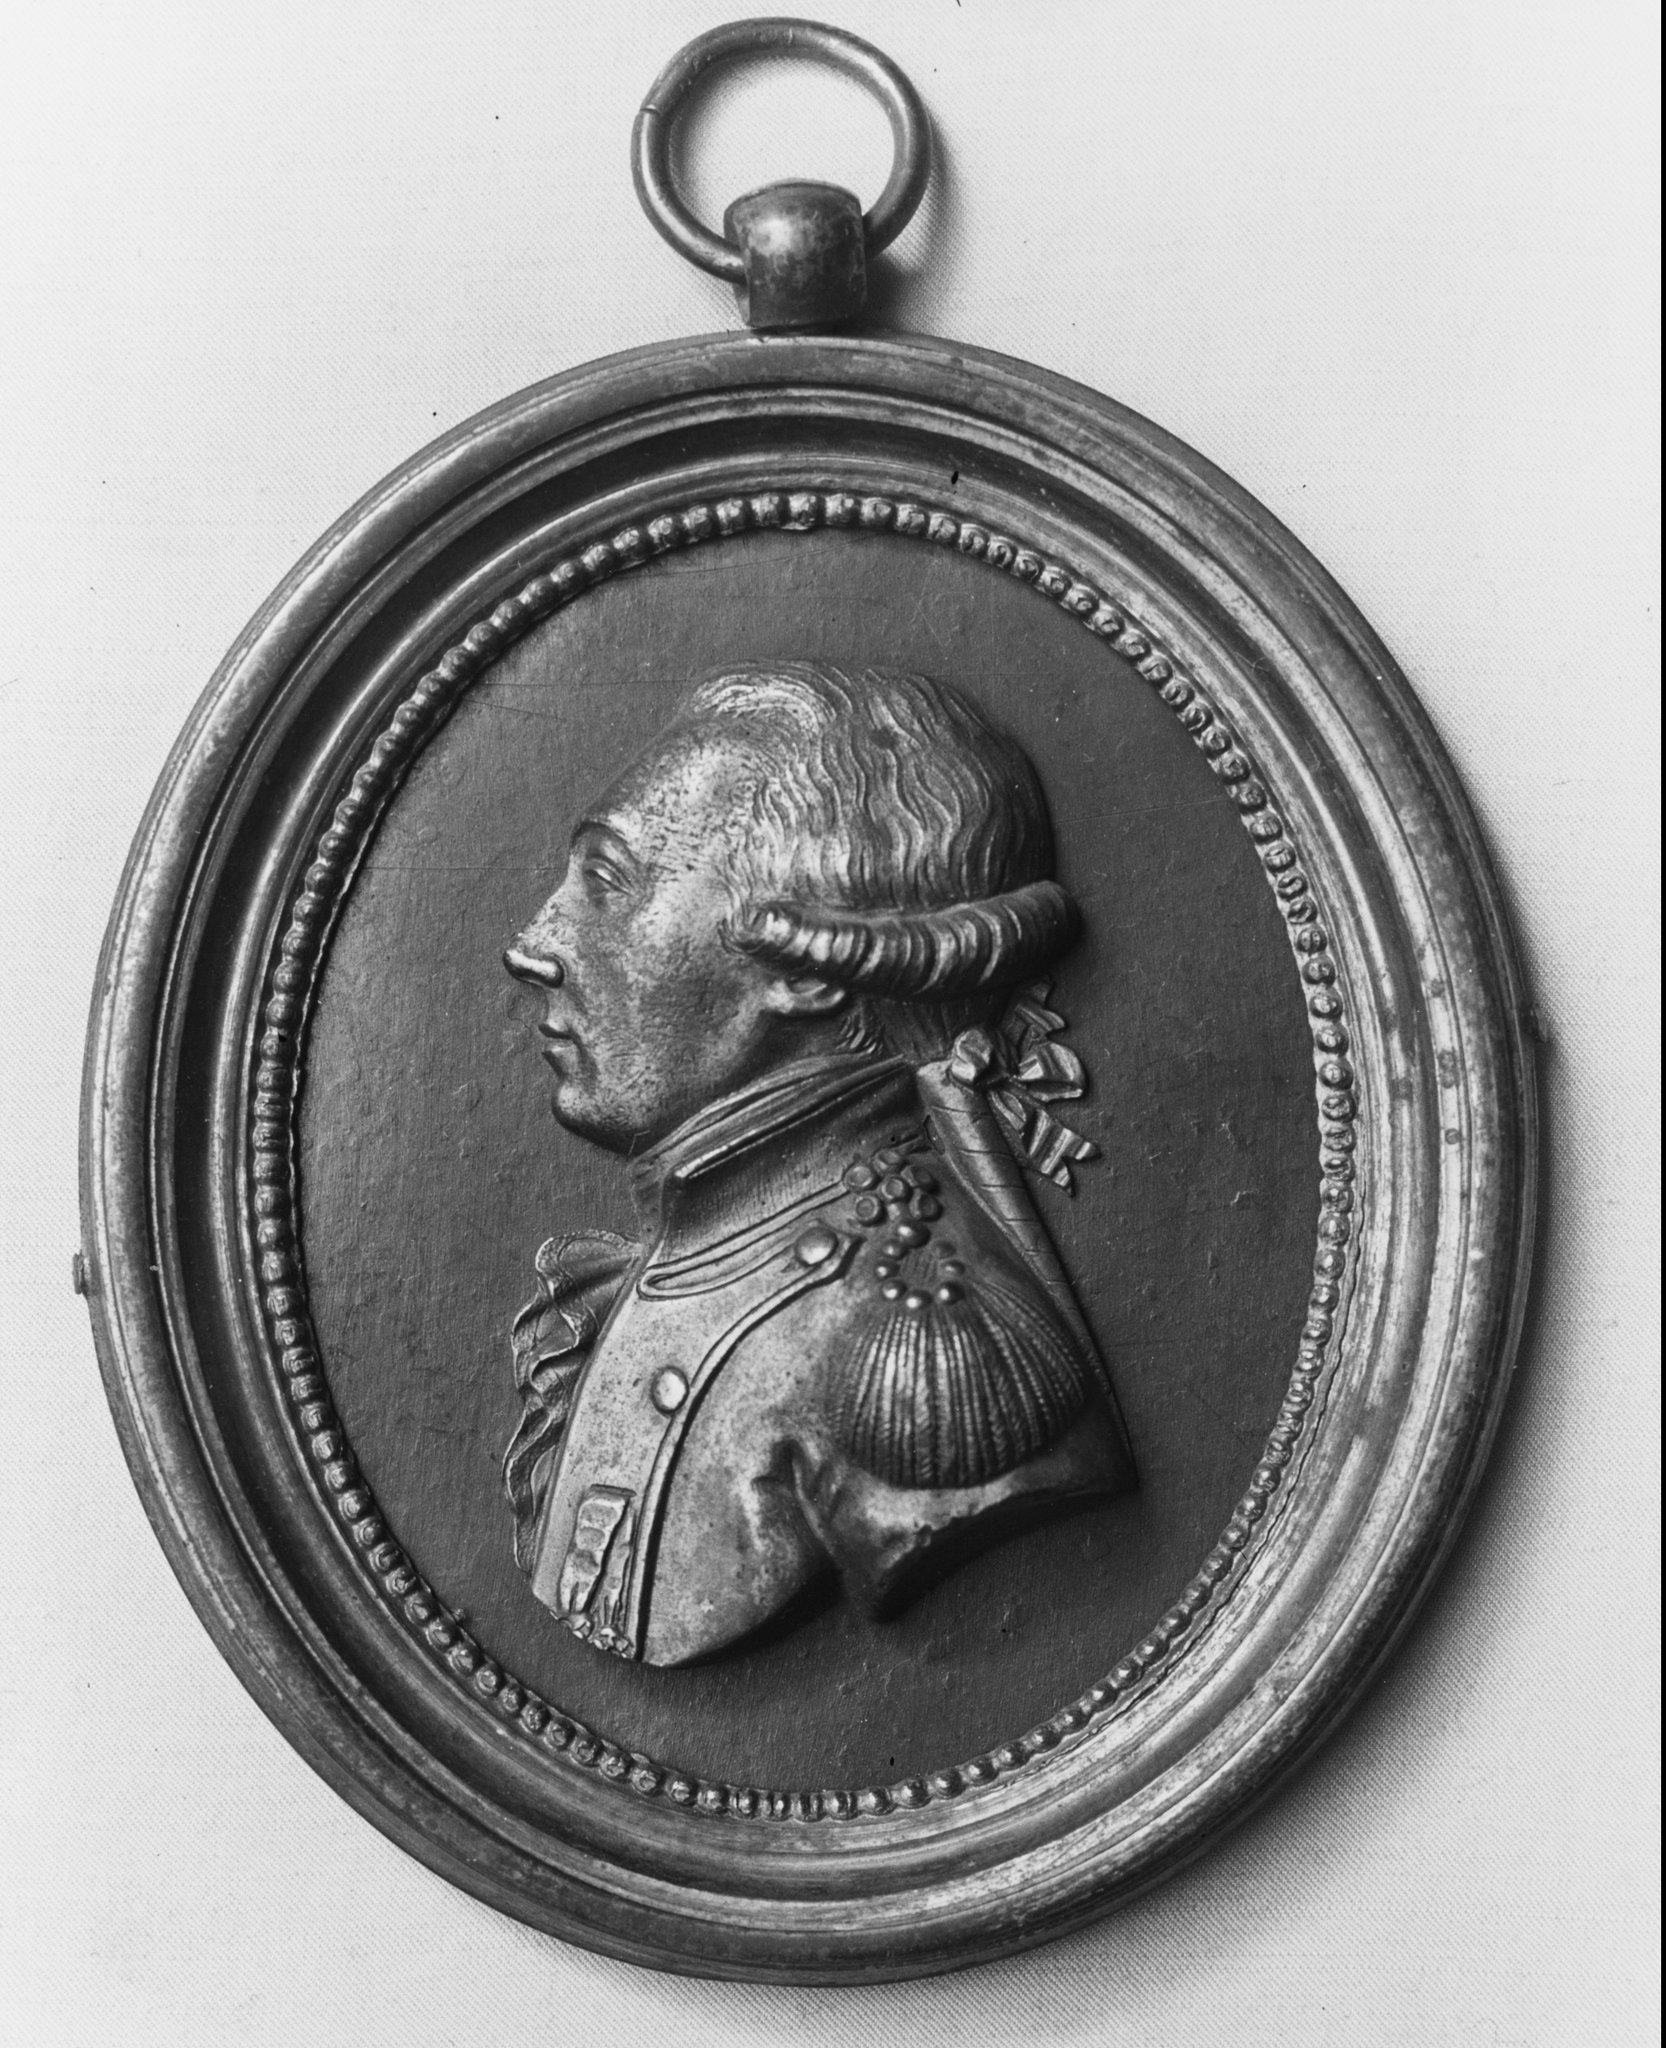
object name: medallion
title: Medallion of the Marquis de Lafayette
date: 1800-1883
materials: gilt bronze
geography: france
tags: men,profiles,marquis de lafayette